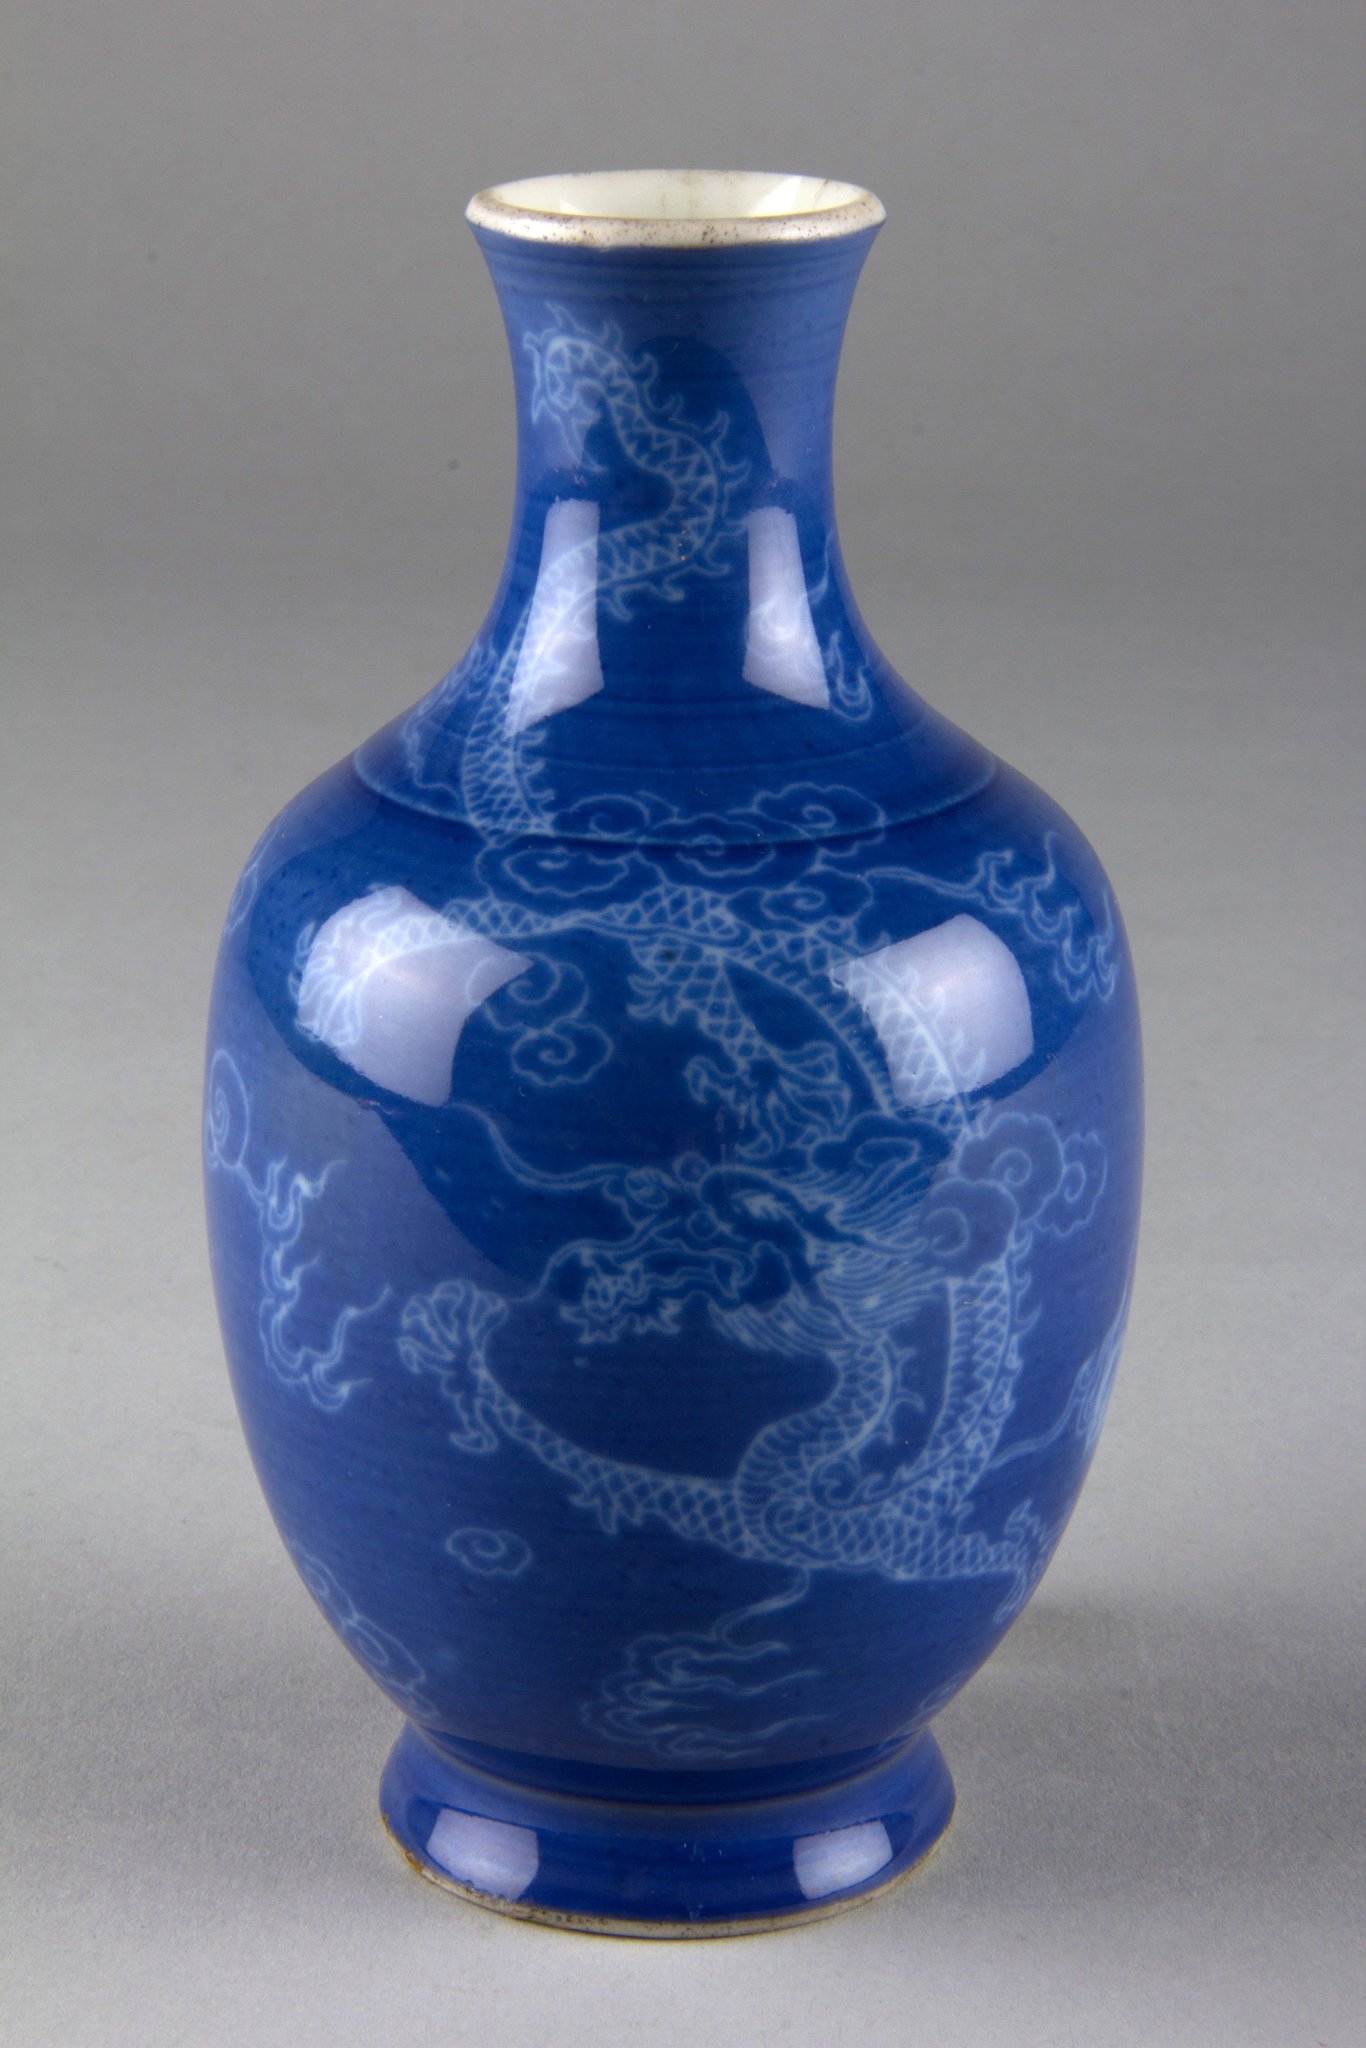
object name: vase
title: Vase with dragon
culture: chinese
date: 1701-1800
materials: glaze, porcelain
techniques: incising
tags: dragons